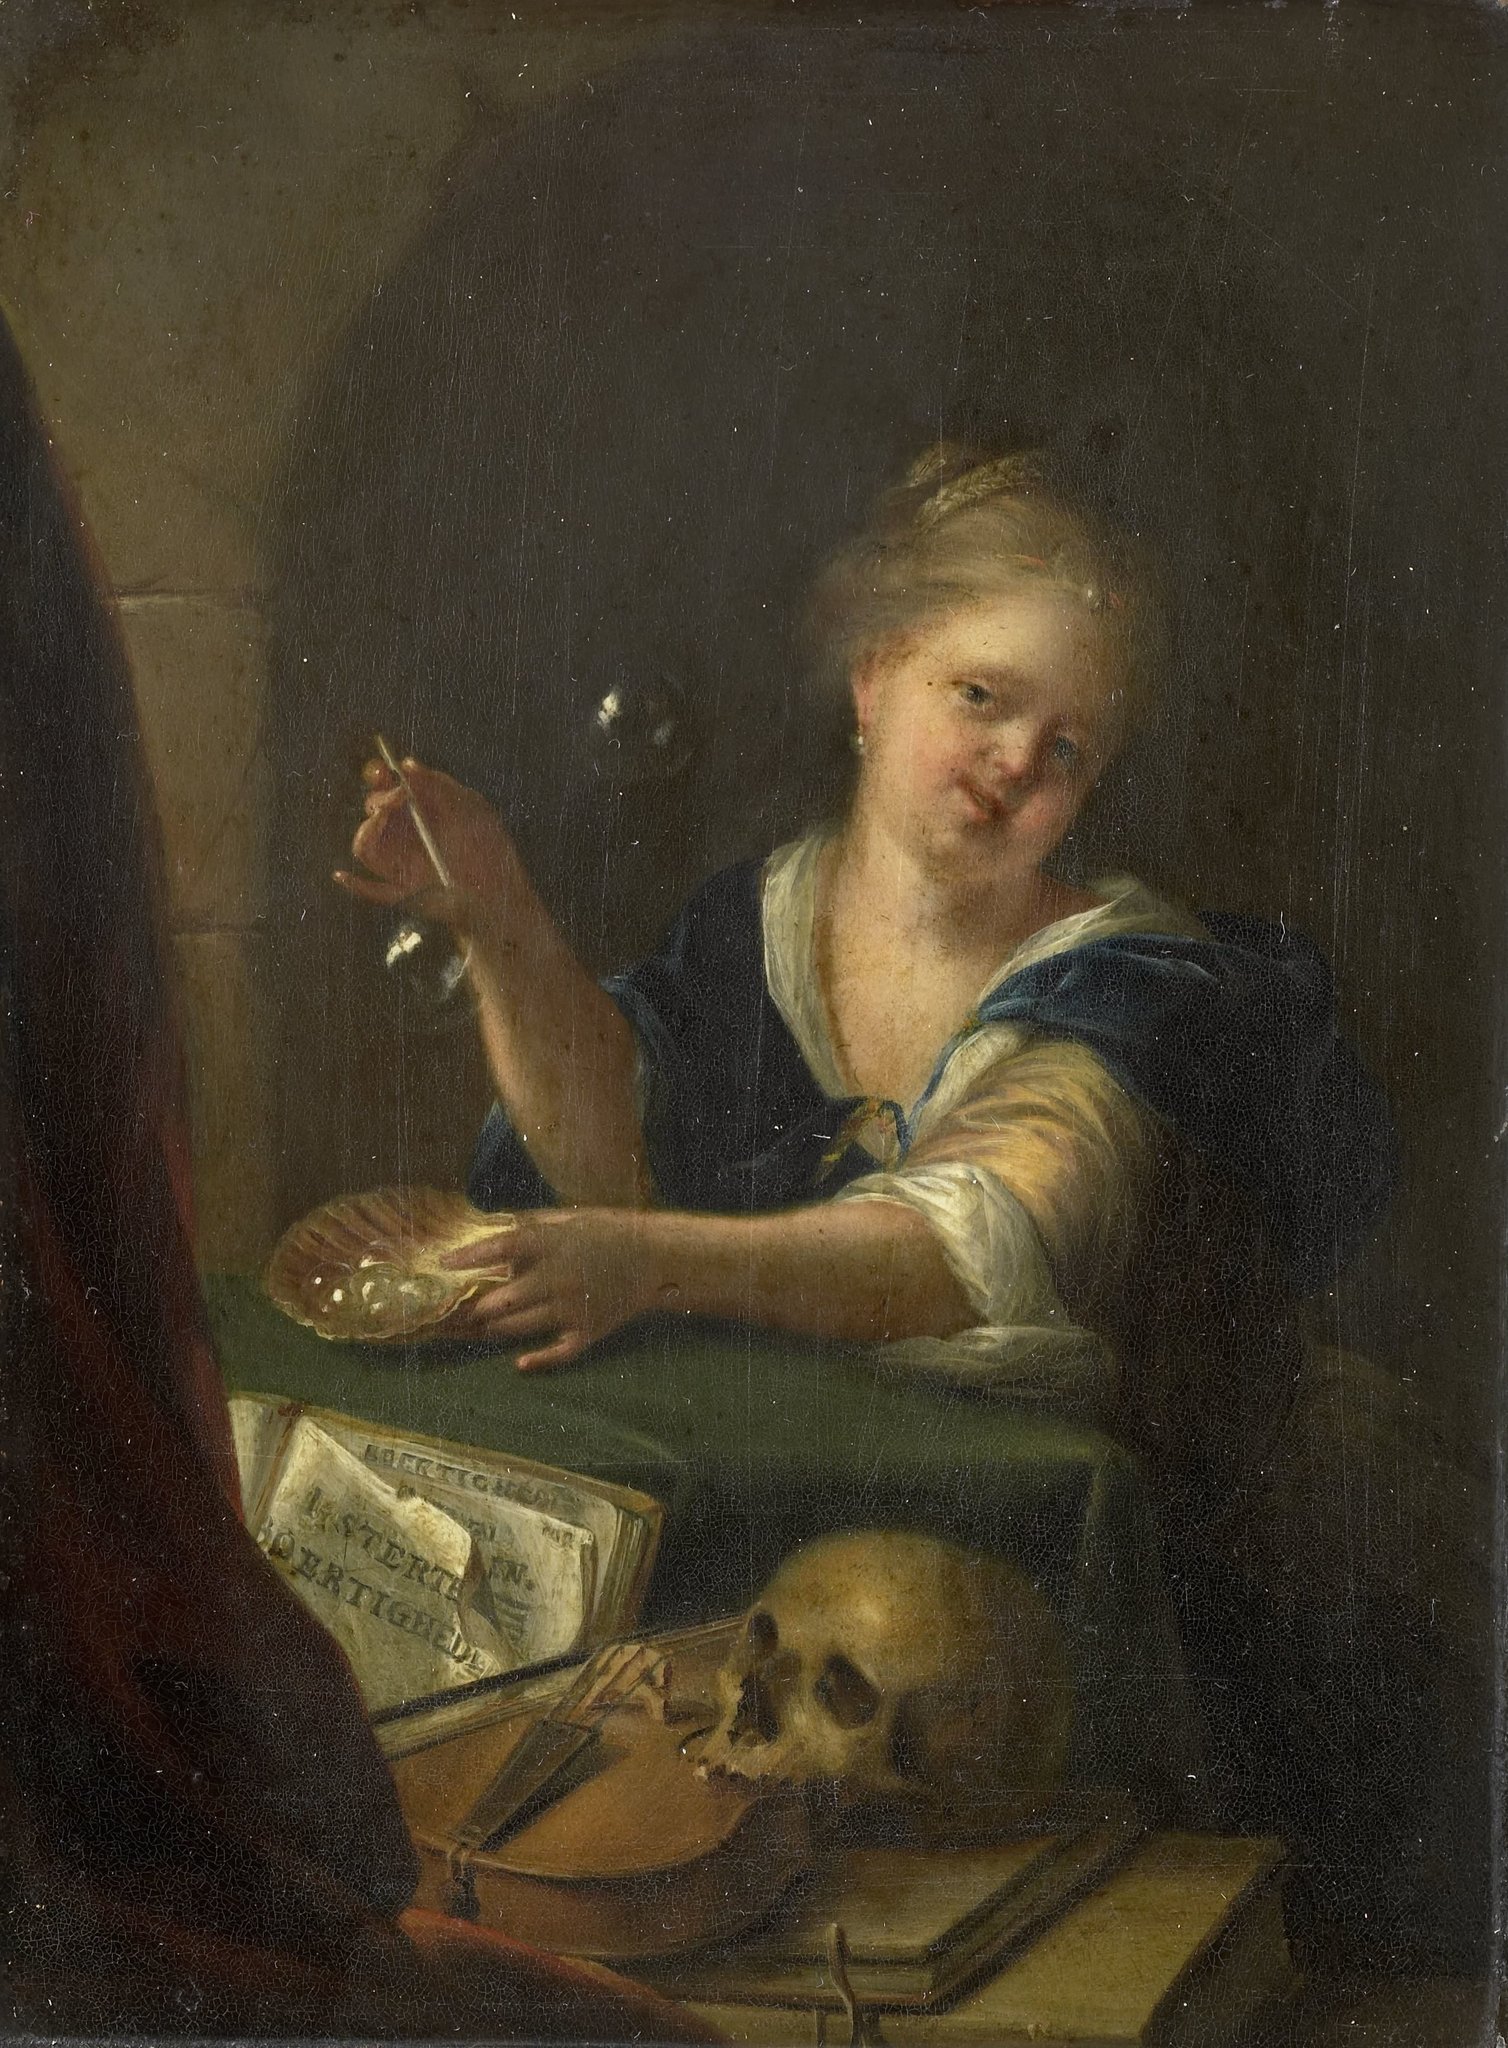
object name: painting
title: Bubble-blowing Girl with a Vanitas Still Life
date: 1680-1775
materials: copper, oil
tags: bubble-blowing (children's games and plays), (personifications of) 'vanitas', the vanity of human life; fragilità humana, fugacità delle grandezze & della gloria mondana, meditatione della morte, opera vana, piacere vano, vana gloria, vanità (ripa), violin, fiddle, skull as symbol of 'vanitas', (children or putti) blowing bubbles, 'homo bulla' ~ scene symbolizing 'vanitas'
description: Bellenblazend meisje bij een vanitas stilleven bestaande uit boeken, een viool en een schedel .